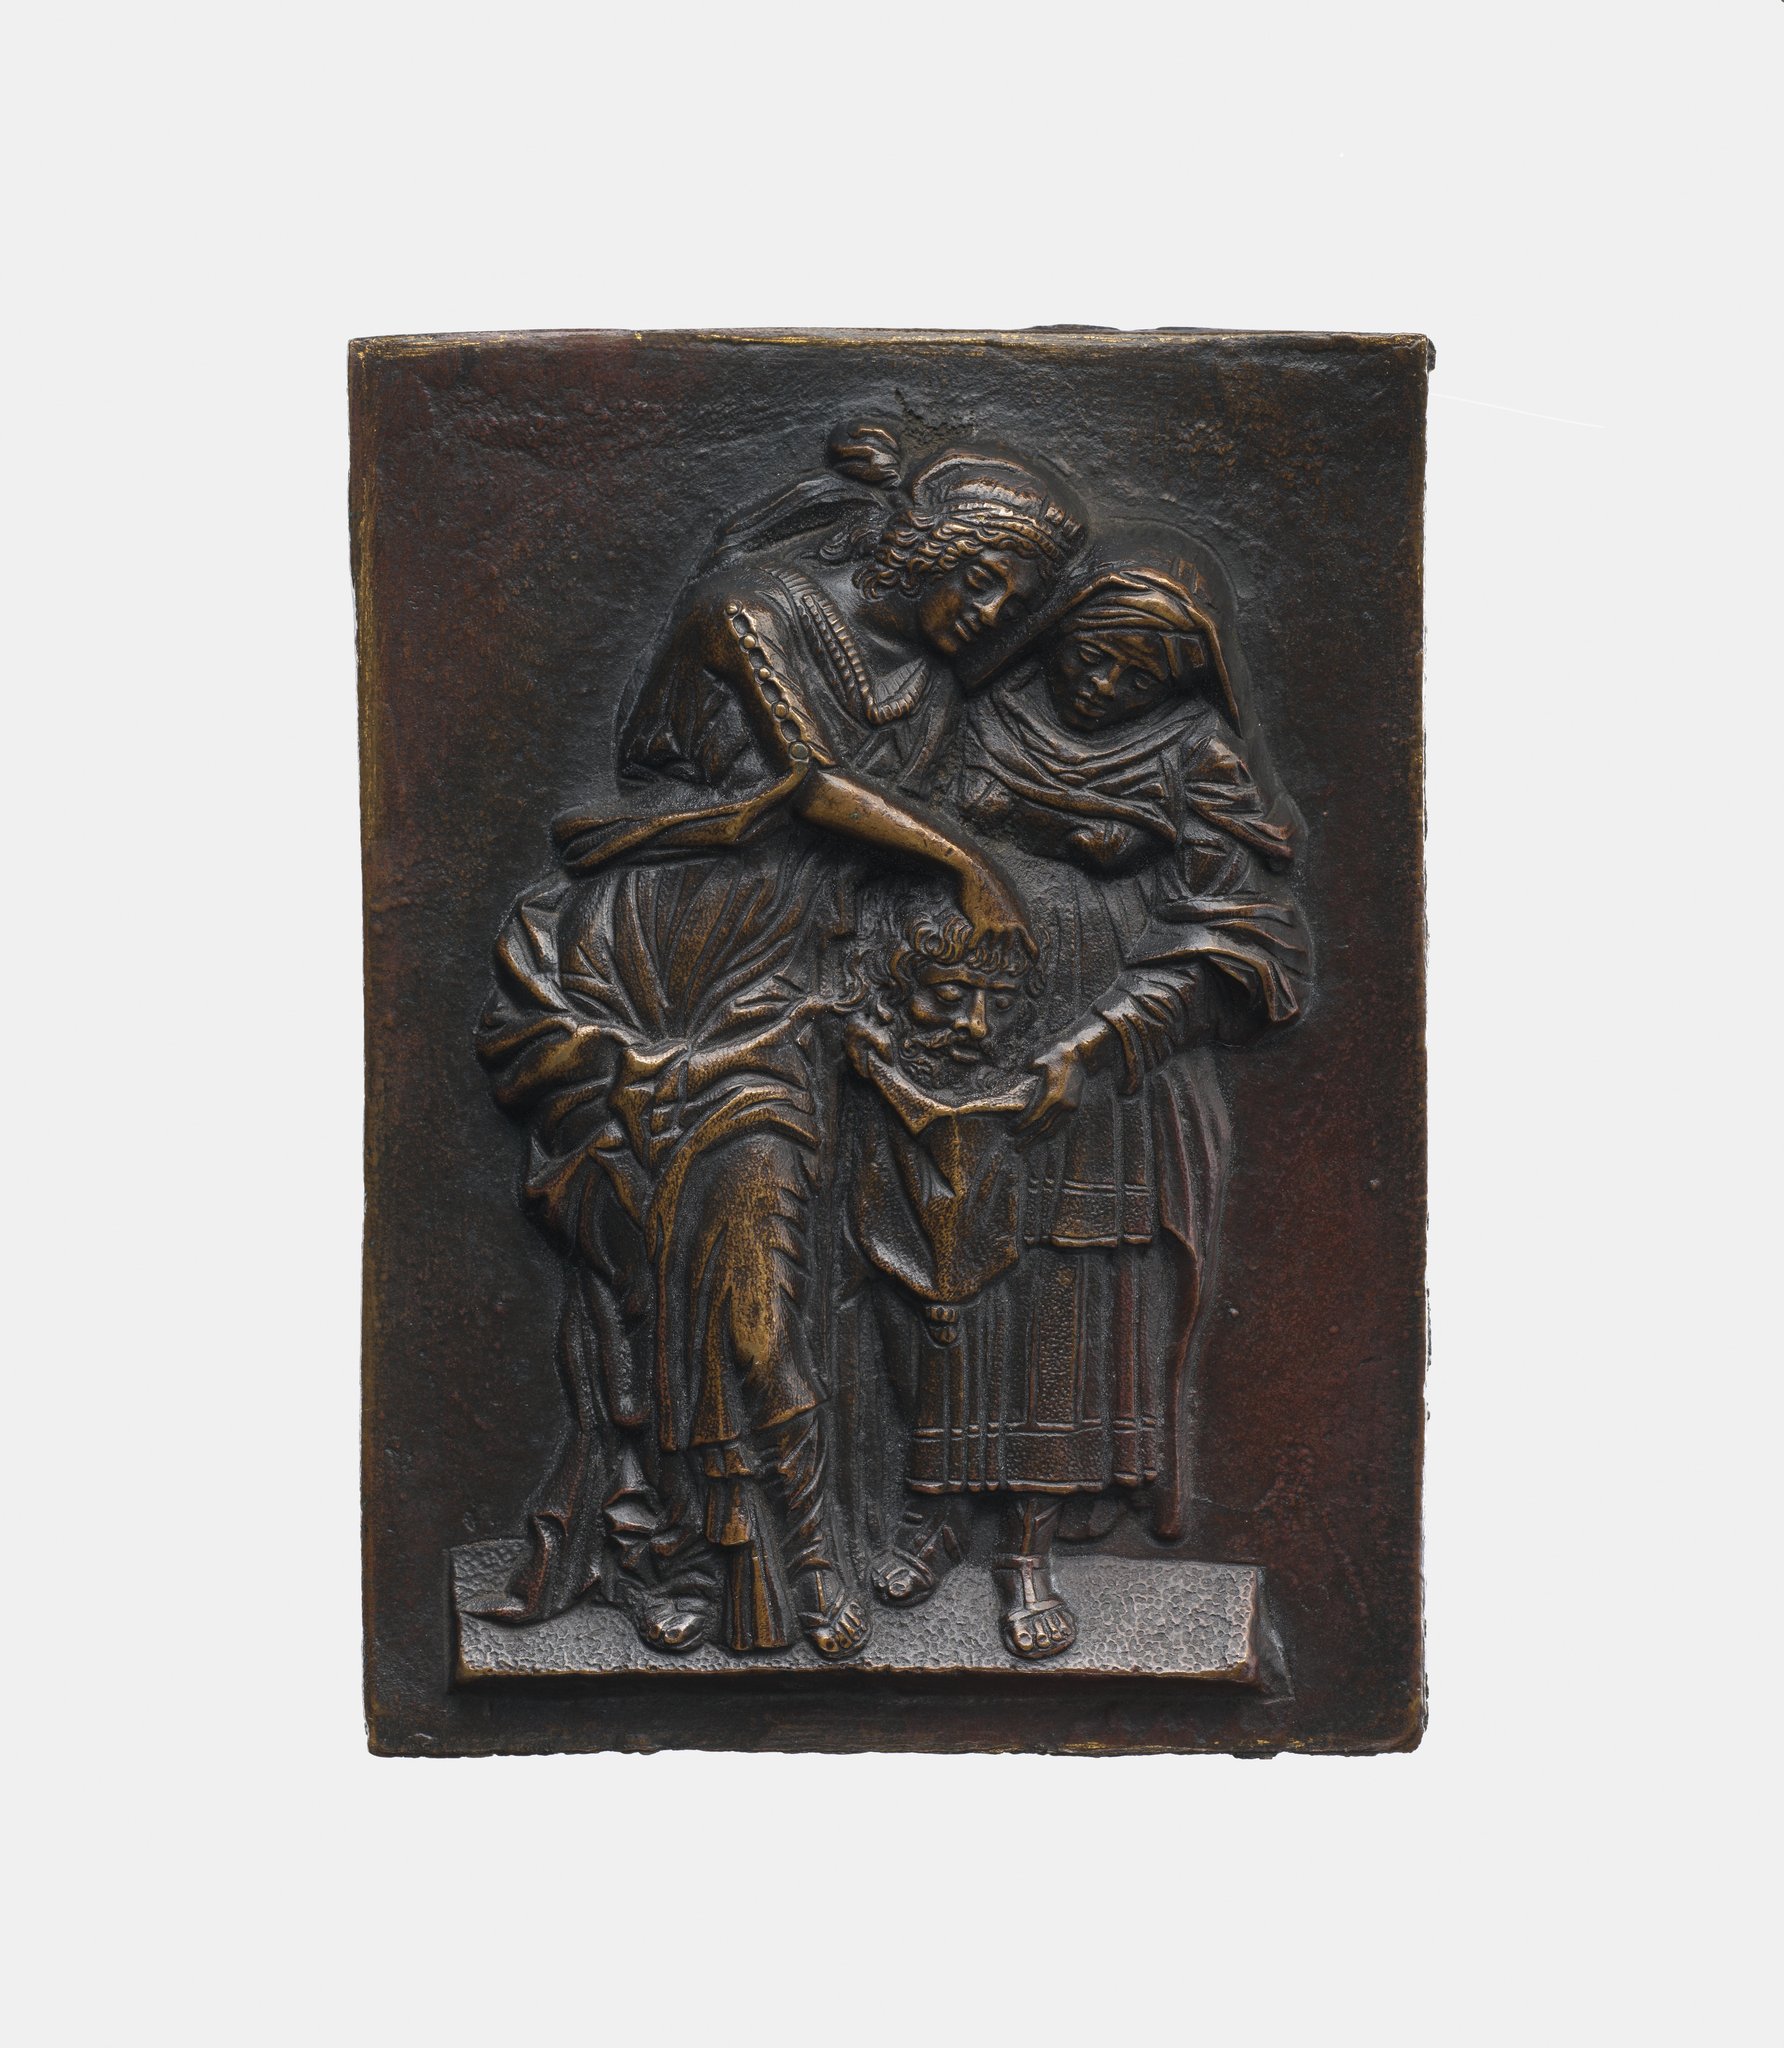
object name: plaquette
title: Judith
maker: andrea briosco, called riccio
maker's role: artist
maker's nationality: italian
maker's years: 1470-1532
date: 1470-1532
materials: bronze